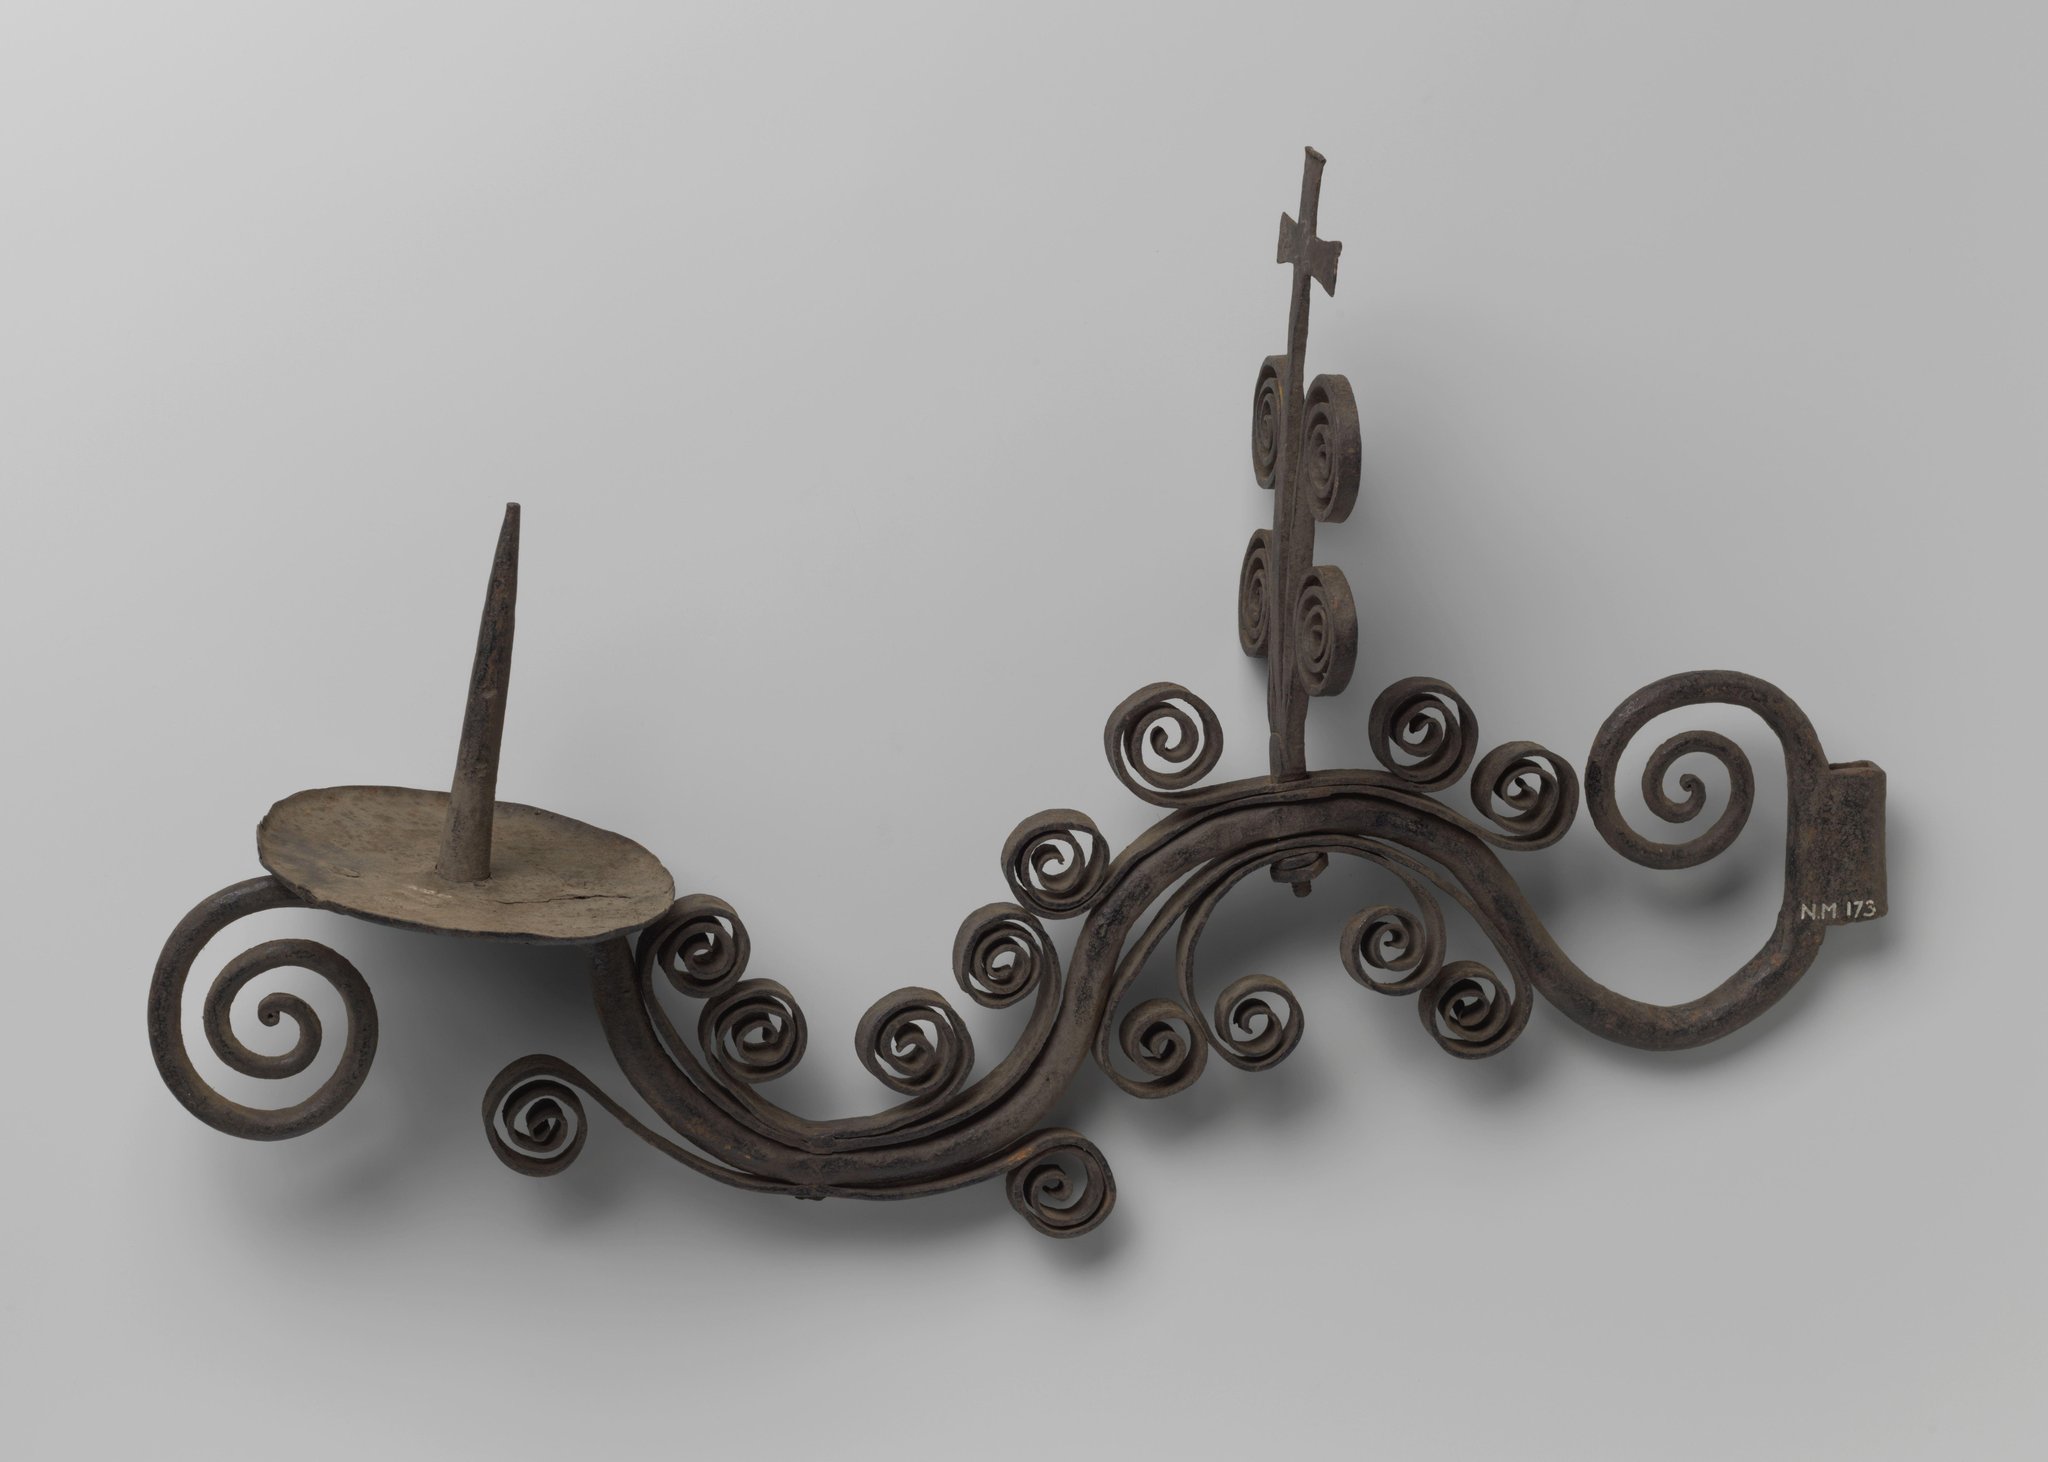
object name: sconce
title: IJzeren gesmede wandarm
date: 1400-1950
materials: iron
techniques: forging